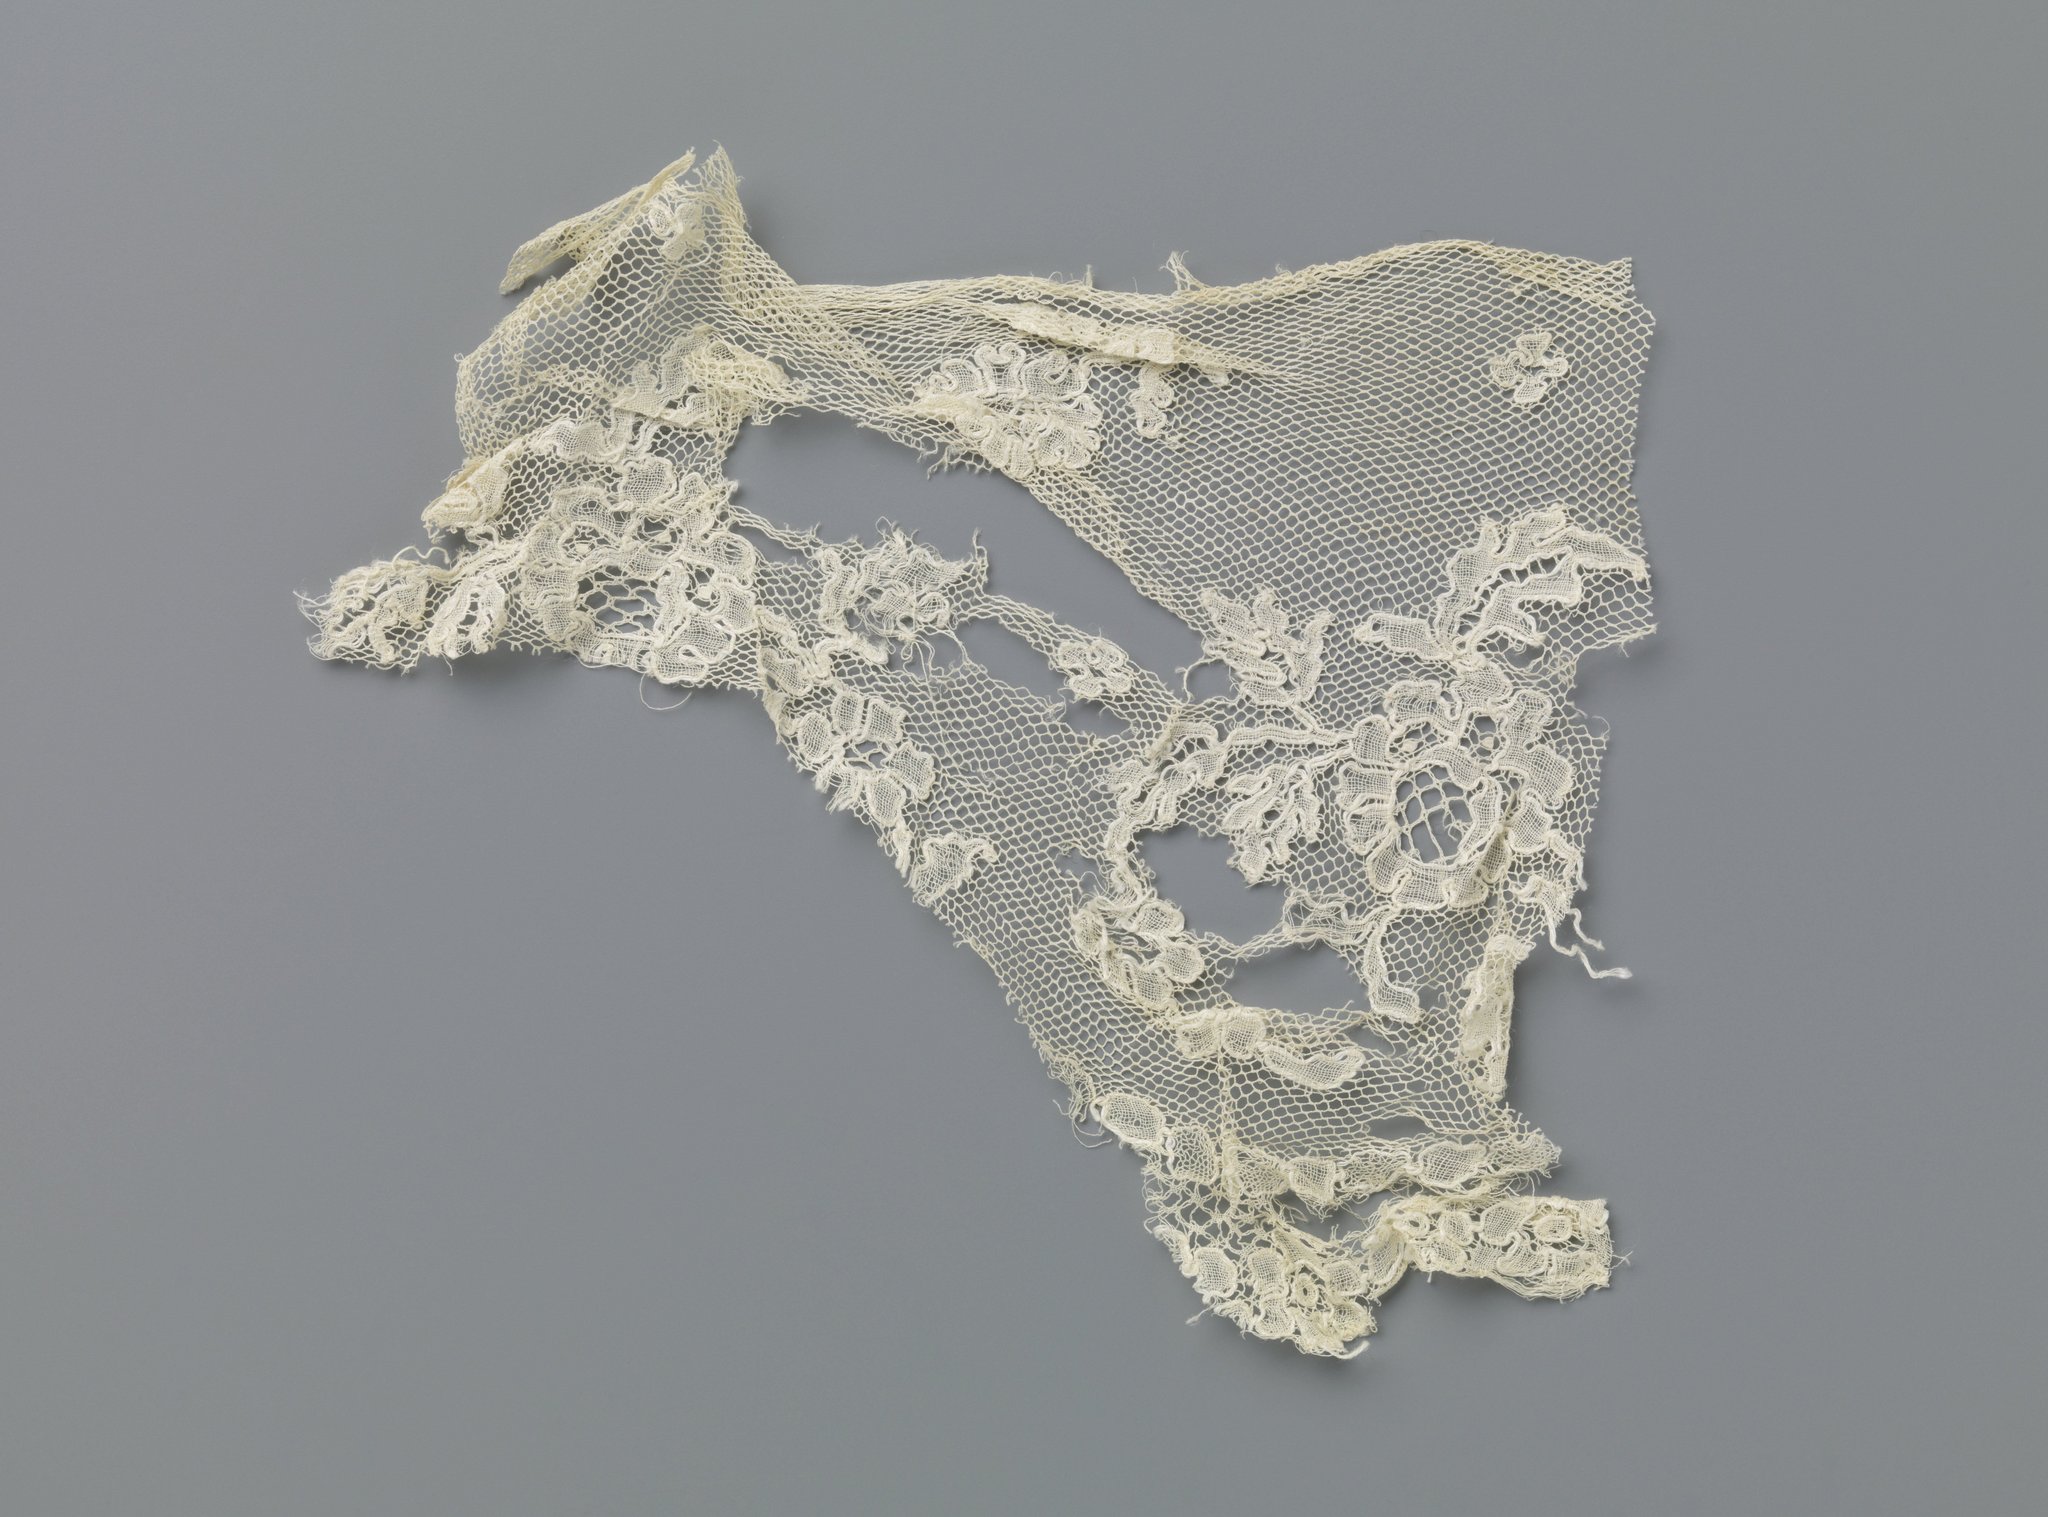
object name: strip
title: Strook kloskant met parel- en rozetlijst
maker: Anonymous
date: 1830-1850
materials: linen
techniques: lace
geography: ieper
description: Op de traliegrond, een Mechelse grond (ook wel ijsgrond genoemd), met enkele gestrooide vierpasvormige moesjes staat een lopend patroon. Langs de binnenkant staan kleine hangende rozetakjes, in het midden een duinroosje aan grotere voluutstengels, die ontspringen bij dezelfde bloem die het sluitstuk der zuiver cirkelboogvormige schulpen vormt. De schulpen bestaan uit een parel- en rozetlijst, die een middenbaan met rasterwerk insluiten. Mechelse kant.